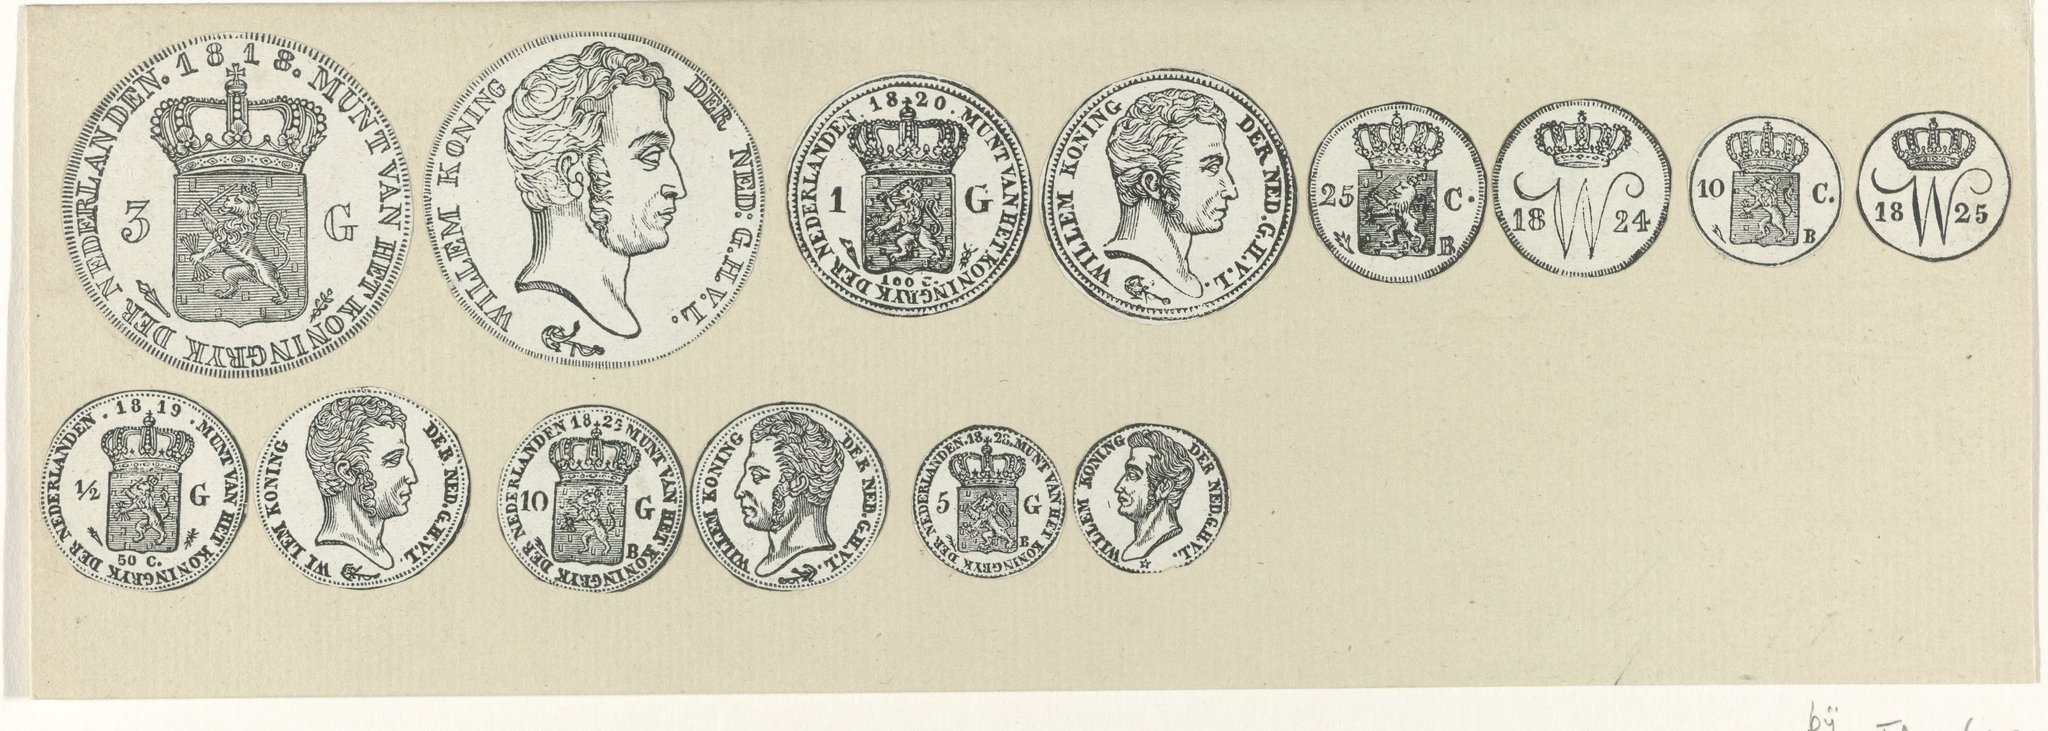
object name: print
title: Zeven nieuwe munten, ca. 1825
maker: Anonymous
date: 1825-1830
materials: paper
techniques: woodcut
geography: netherlands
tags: the hague, berlin, william i of the netherlands, coin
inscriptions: collector's mark: Lugt 2228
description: Zeven nieuwe munten van het Koninkrijk der Nederlanden, beide zijden afgebeeld, uitgeknipt en opgeplakt in twee rijen. Met de jaartallen tussen 1818-1826. Met de beeltenis of initiaal van koning Willem I op een zijde en de waarde op de andere zijde. Munten aflopend in grootte: 3G, 1G, 25c, 10c, ½G, 10G, 5G.